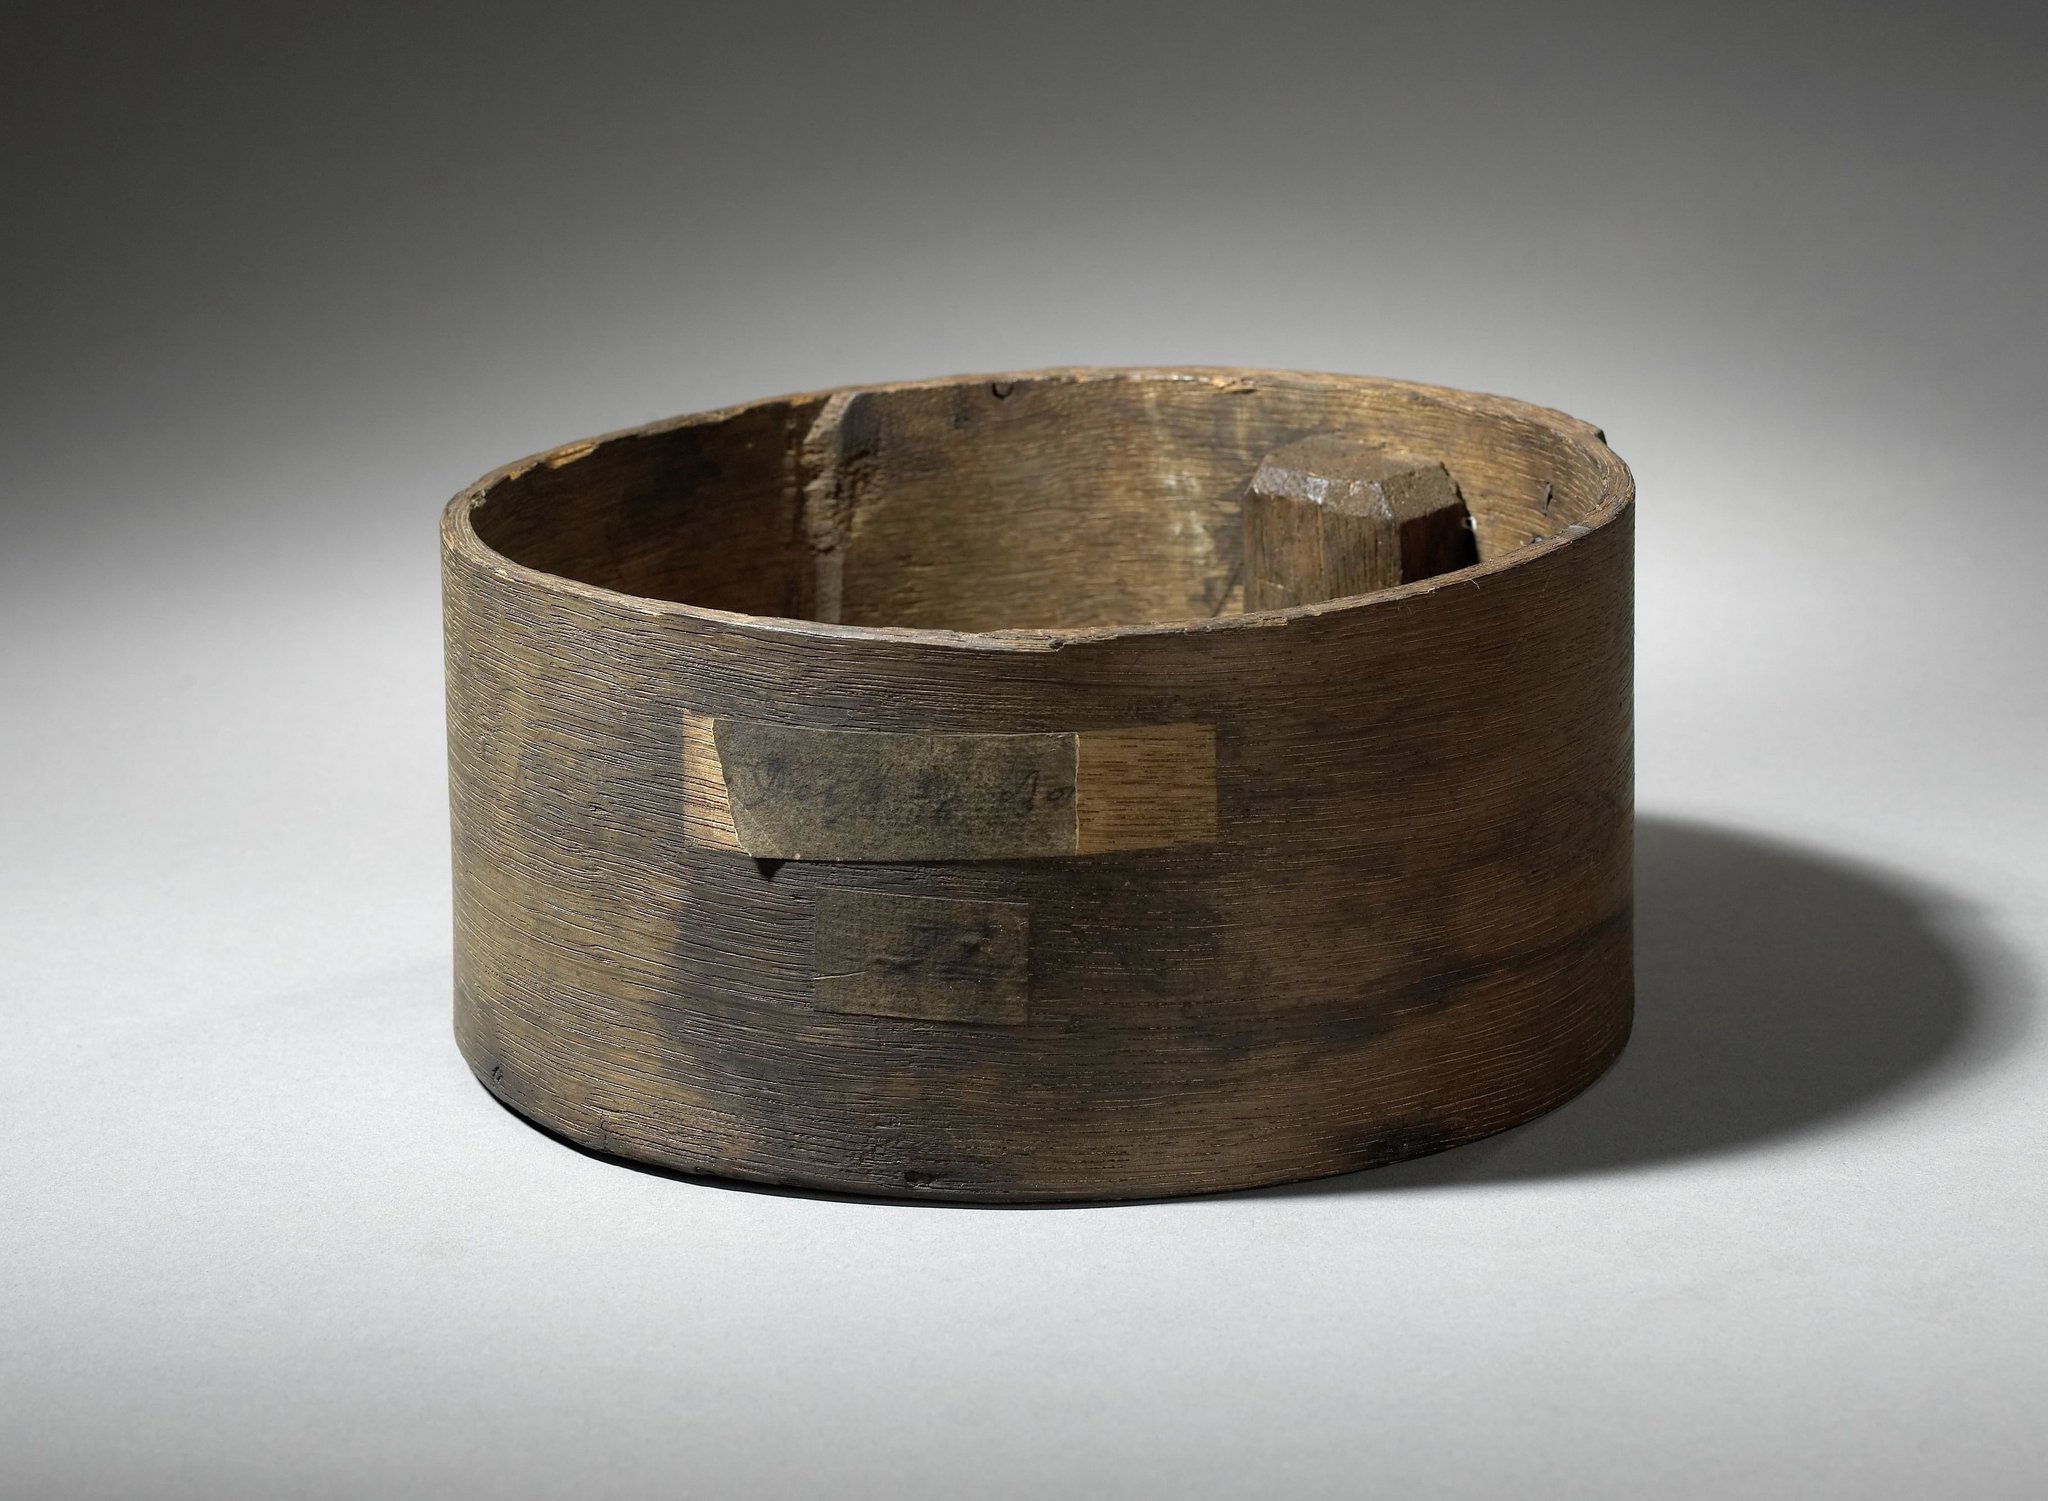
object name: inhoudsmaat droge waren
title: Maat van 1/16 Boisseau uit Delft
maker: Anonymous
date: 1800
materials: wood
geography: delft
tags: delft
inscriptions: number: ‘22’, title: ‘Delft 1/16 Boisseau’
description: Spanen maat van 1/16 Boisseau, voorzien van etiket en nummer.